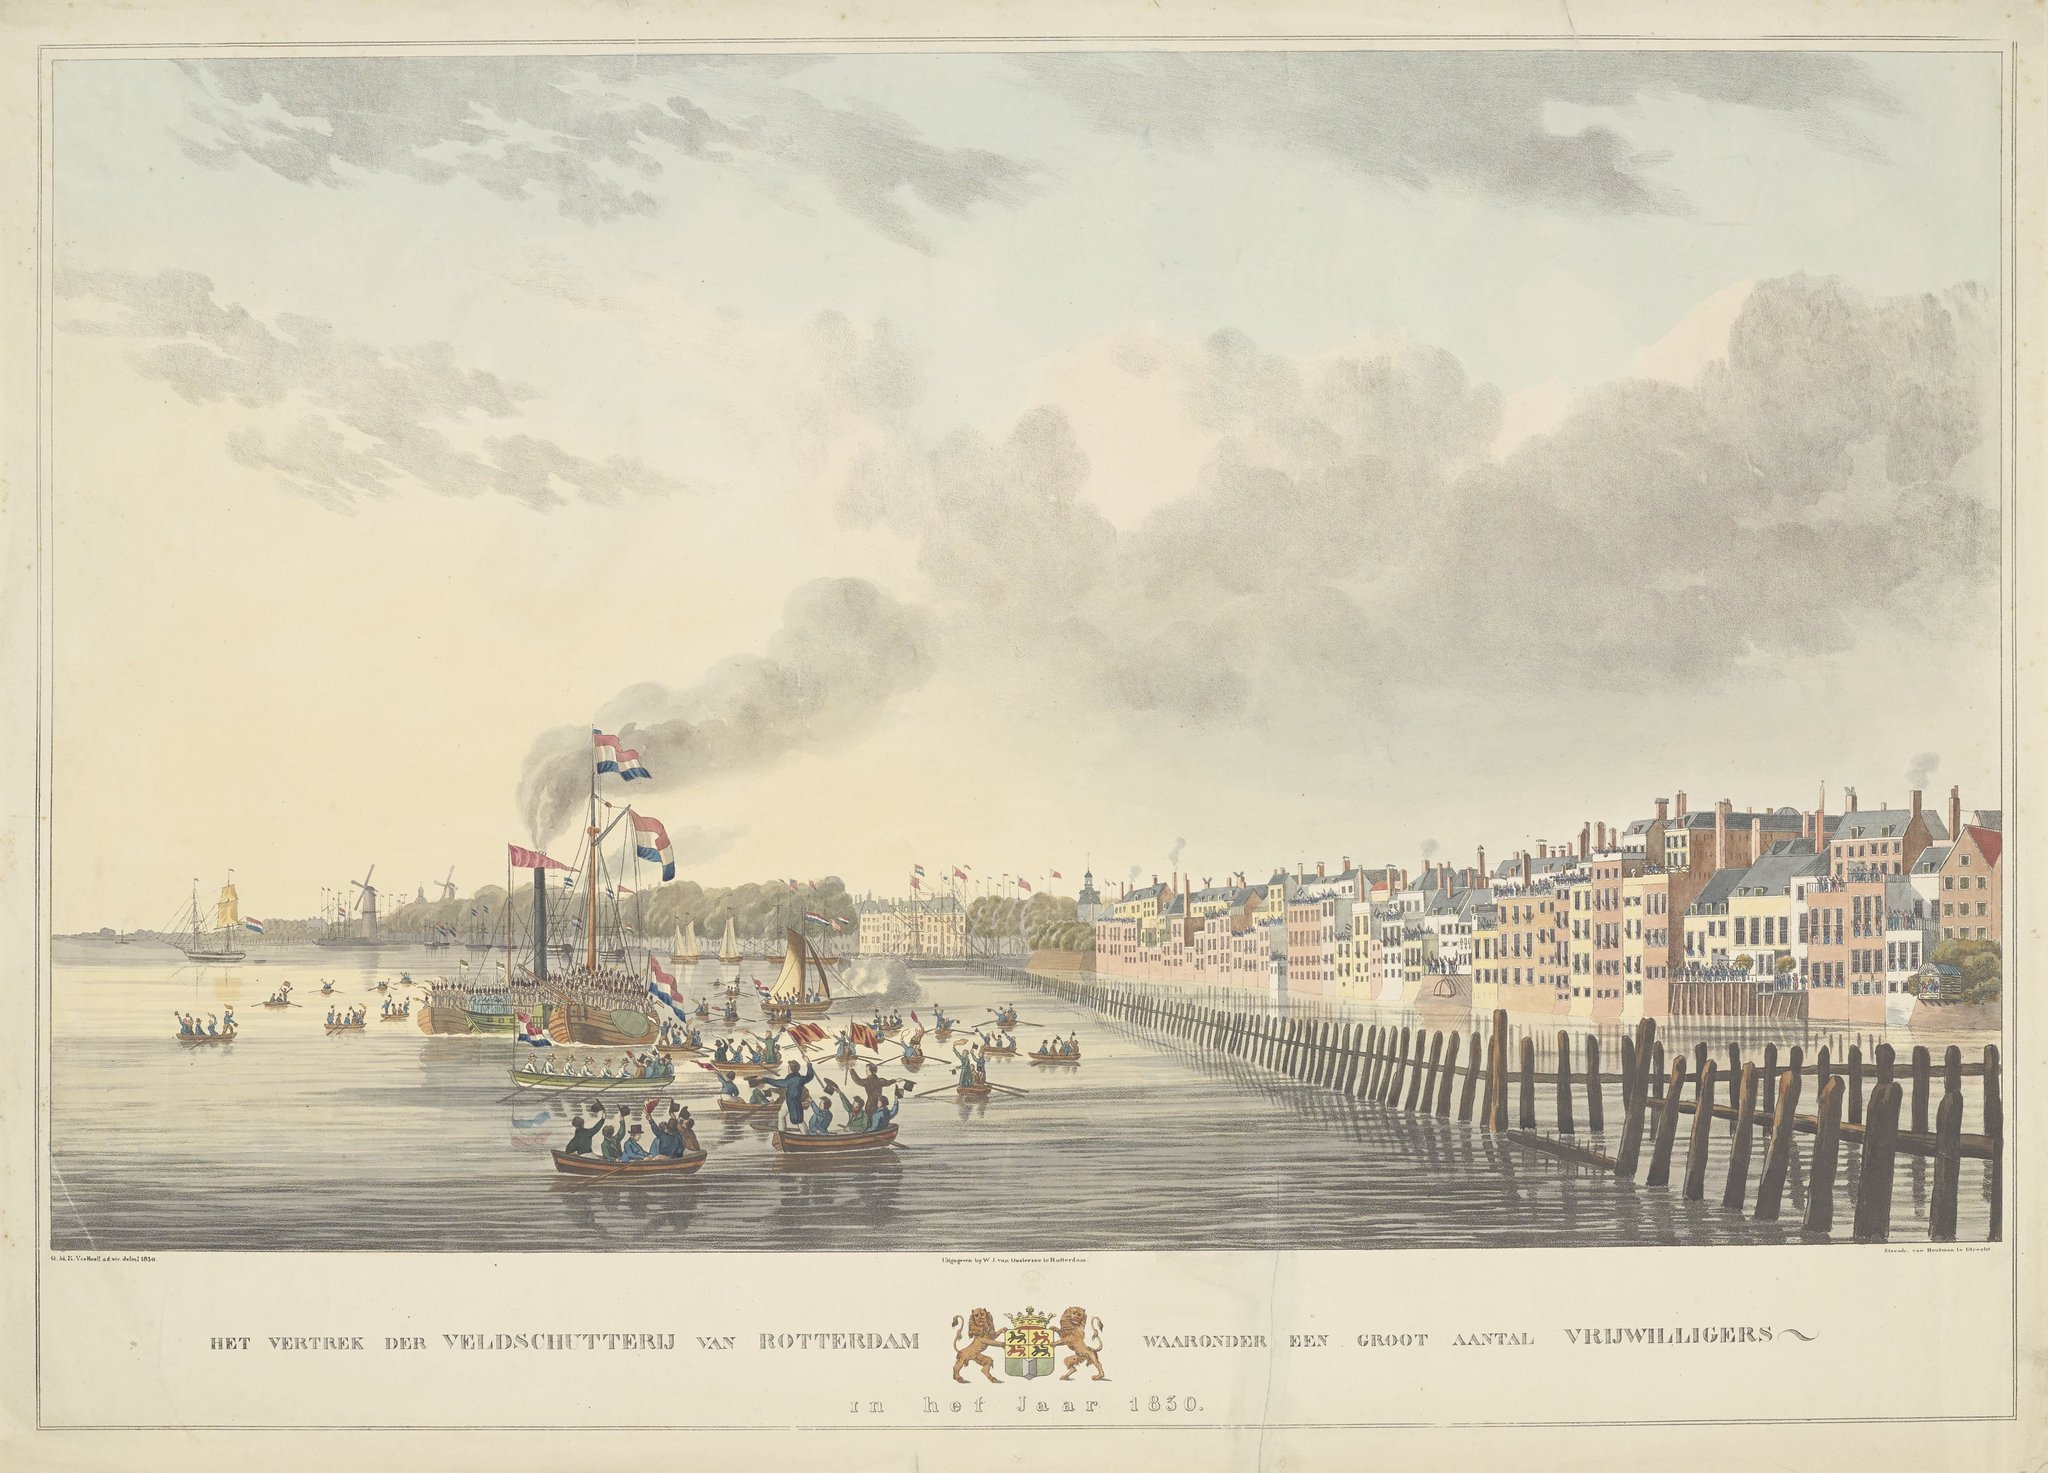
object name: print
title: Het vetrek der Veldschutterij van Rotterdam waaronder een groot aantal Vrijwilligers, in het Jaar 1830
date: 1830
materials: paper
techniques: hand coloring, lithograph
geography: utrecht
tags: troop movements, transportation (+ citizen soldiery, civil guard, citizen militia), steamship, motorship (+ propulsion of vehicle, ship, etc. by steam), rotterdam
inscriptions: collector's mark: Lugt 2228, workshop stamp: ‘W.J.V.O.’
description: Gezicht op Rotterdam met in de verte de Boompjes, op het water van de Nieuwe Maas het vertrek van twee zeilschepen en een stoomschip met leden van de veldschutterij van Rotterdam, 20 oktober 1830. Onderaan in de marge het wapen van de stad Rotterdam.